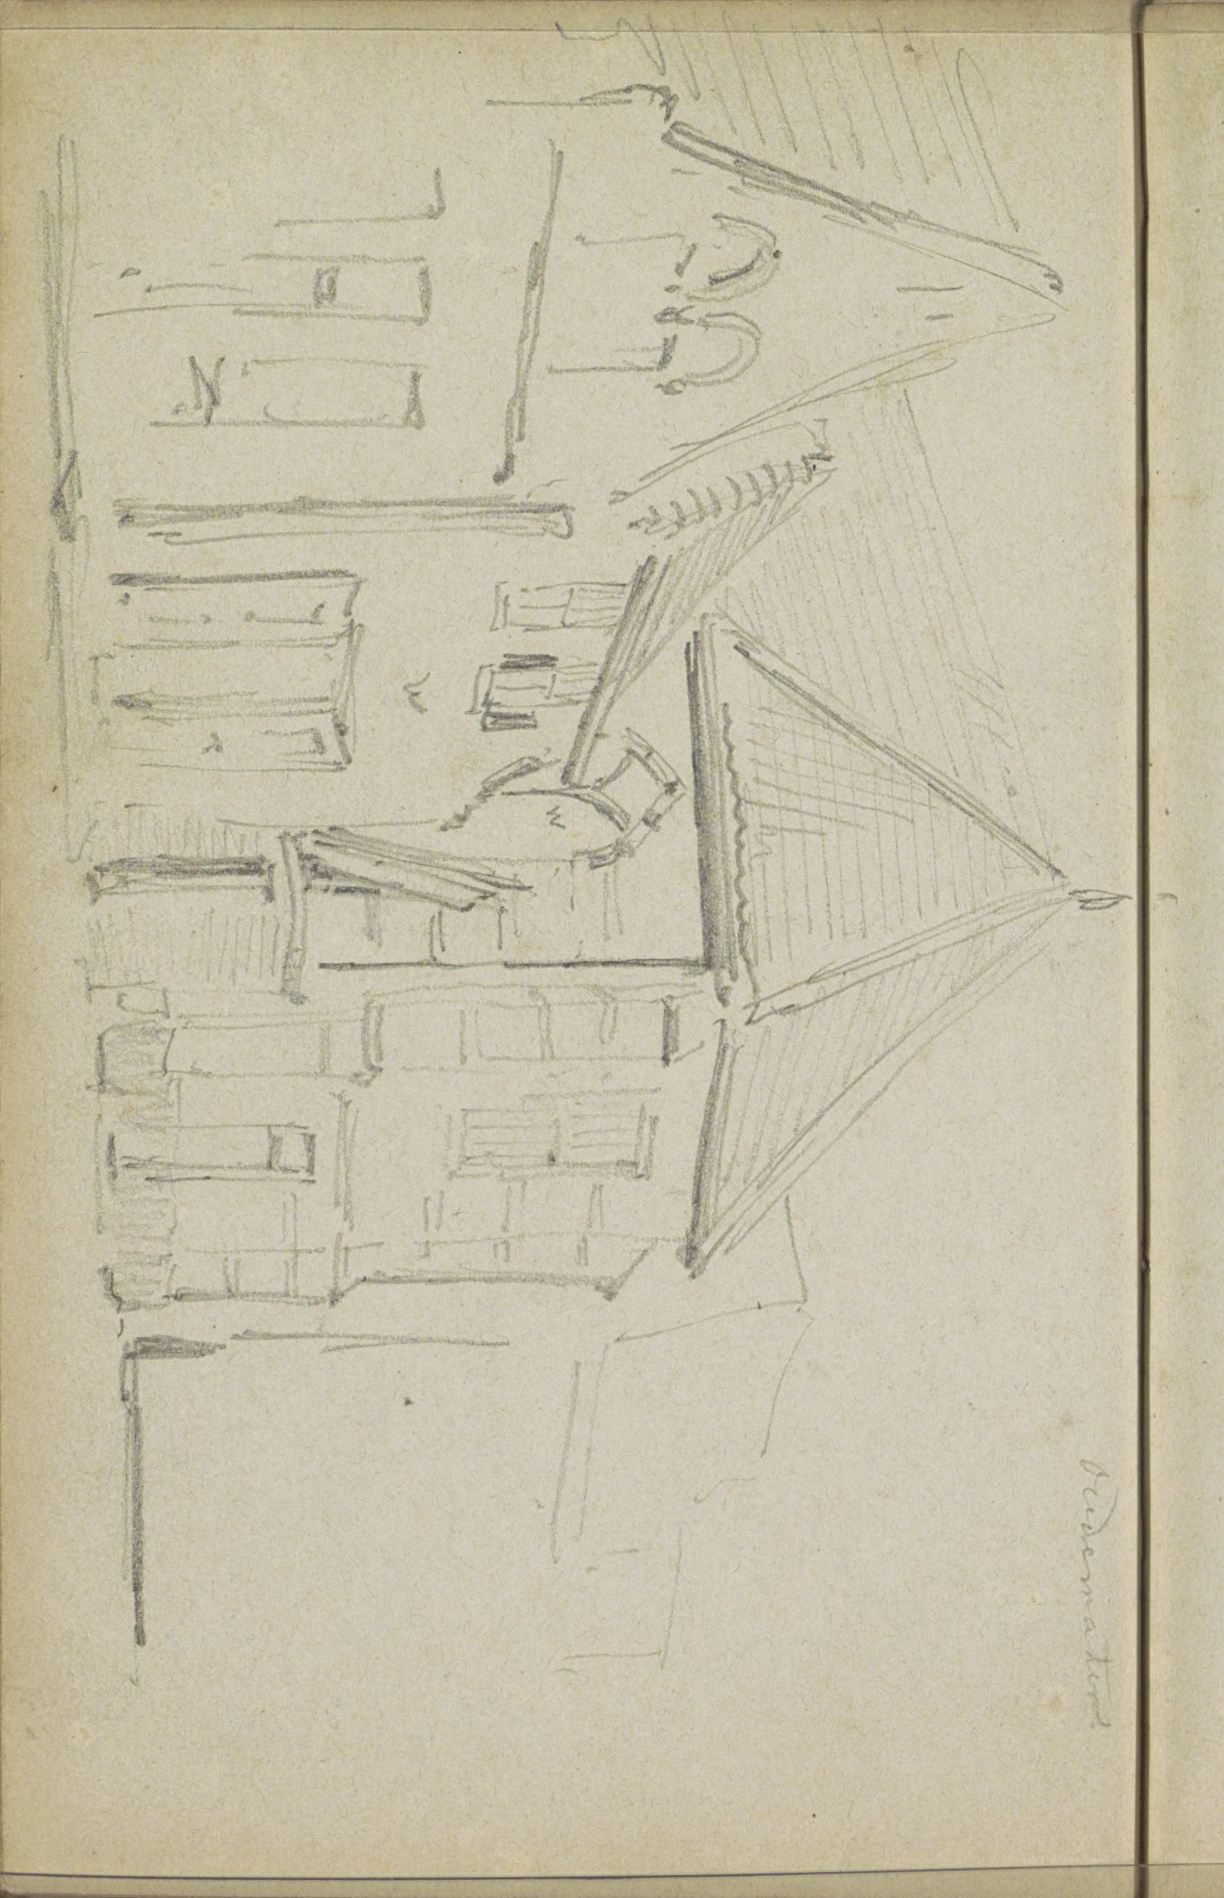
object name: sketchbook leaf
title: Gezicht op vier gebouwen in Oudewater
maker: adrianus eversen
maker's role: draughtsman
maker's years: 1818-1897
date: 1828-1897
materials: paper, pencil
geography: oudewater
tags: urban housing, street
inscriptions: annotation: ‘Oudewater’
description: Gezicht op vier gebouwen langs een weg in Oudewater. Blad 54 verso uit een schetsboek met 69 bladen vervaardigd in de omgeving van Delft, Rotterdam, Oudewater en Harlingen.